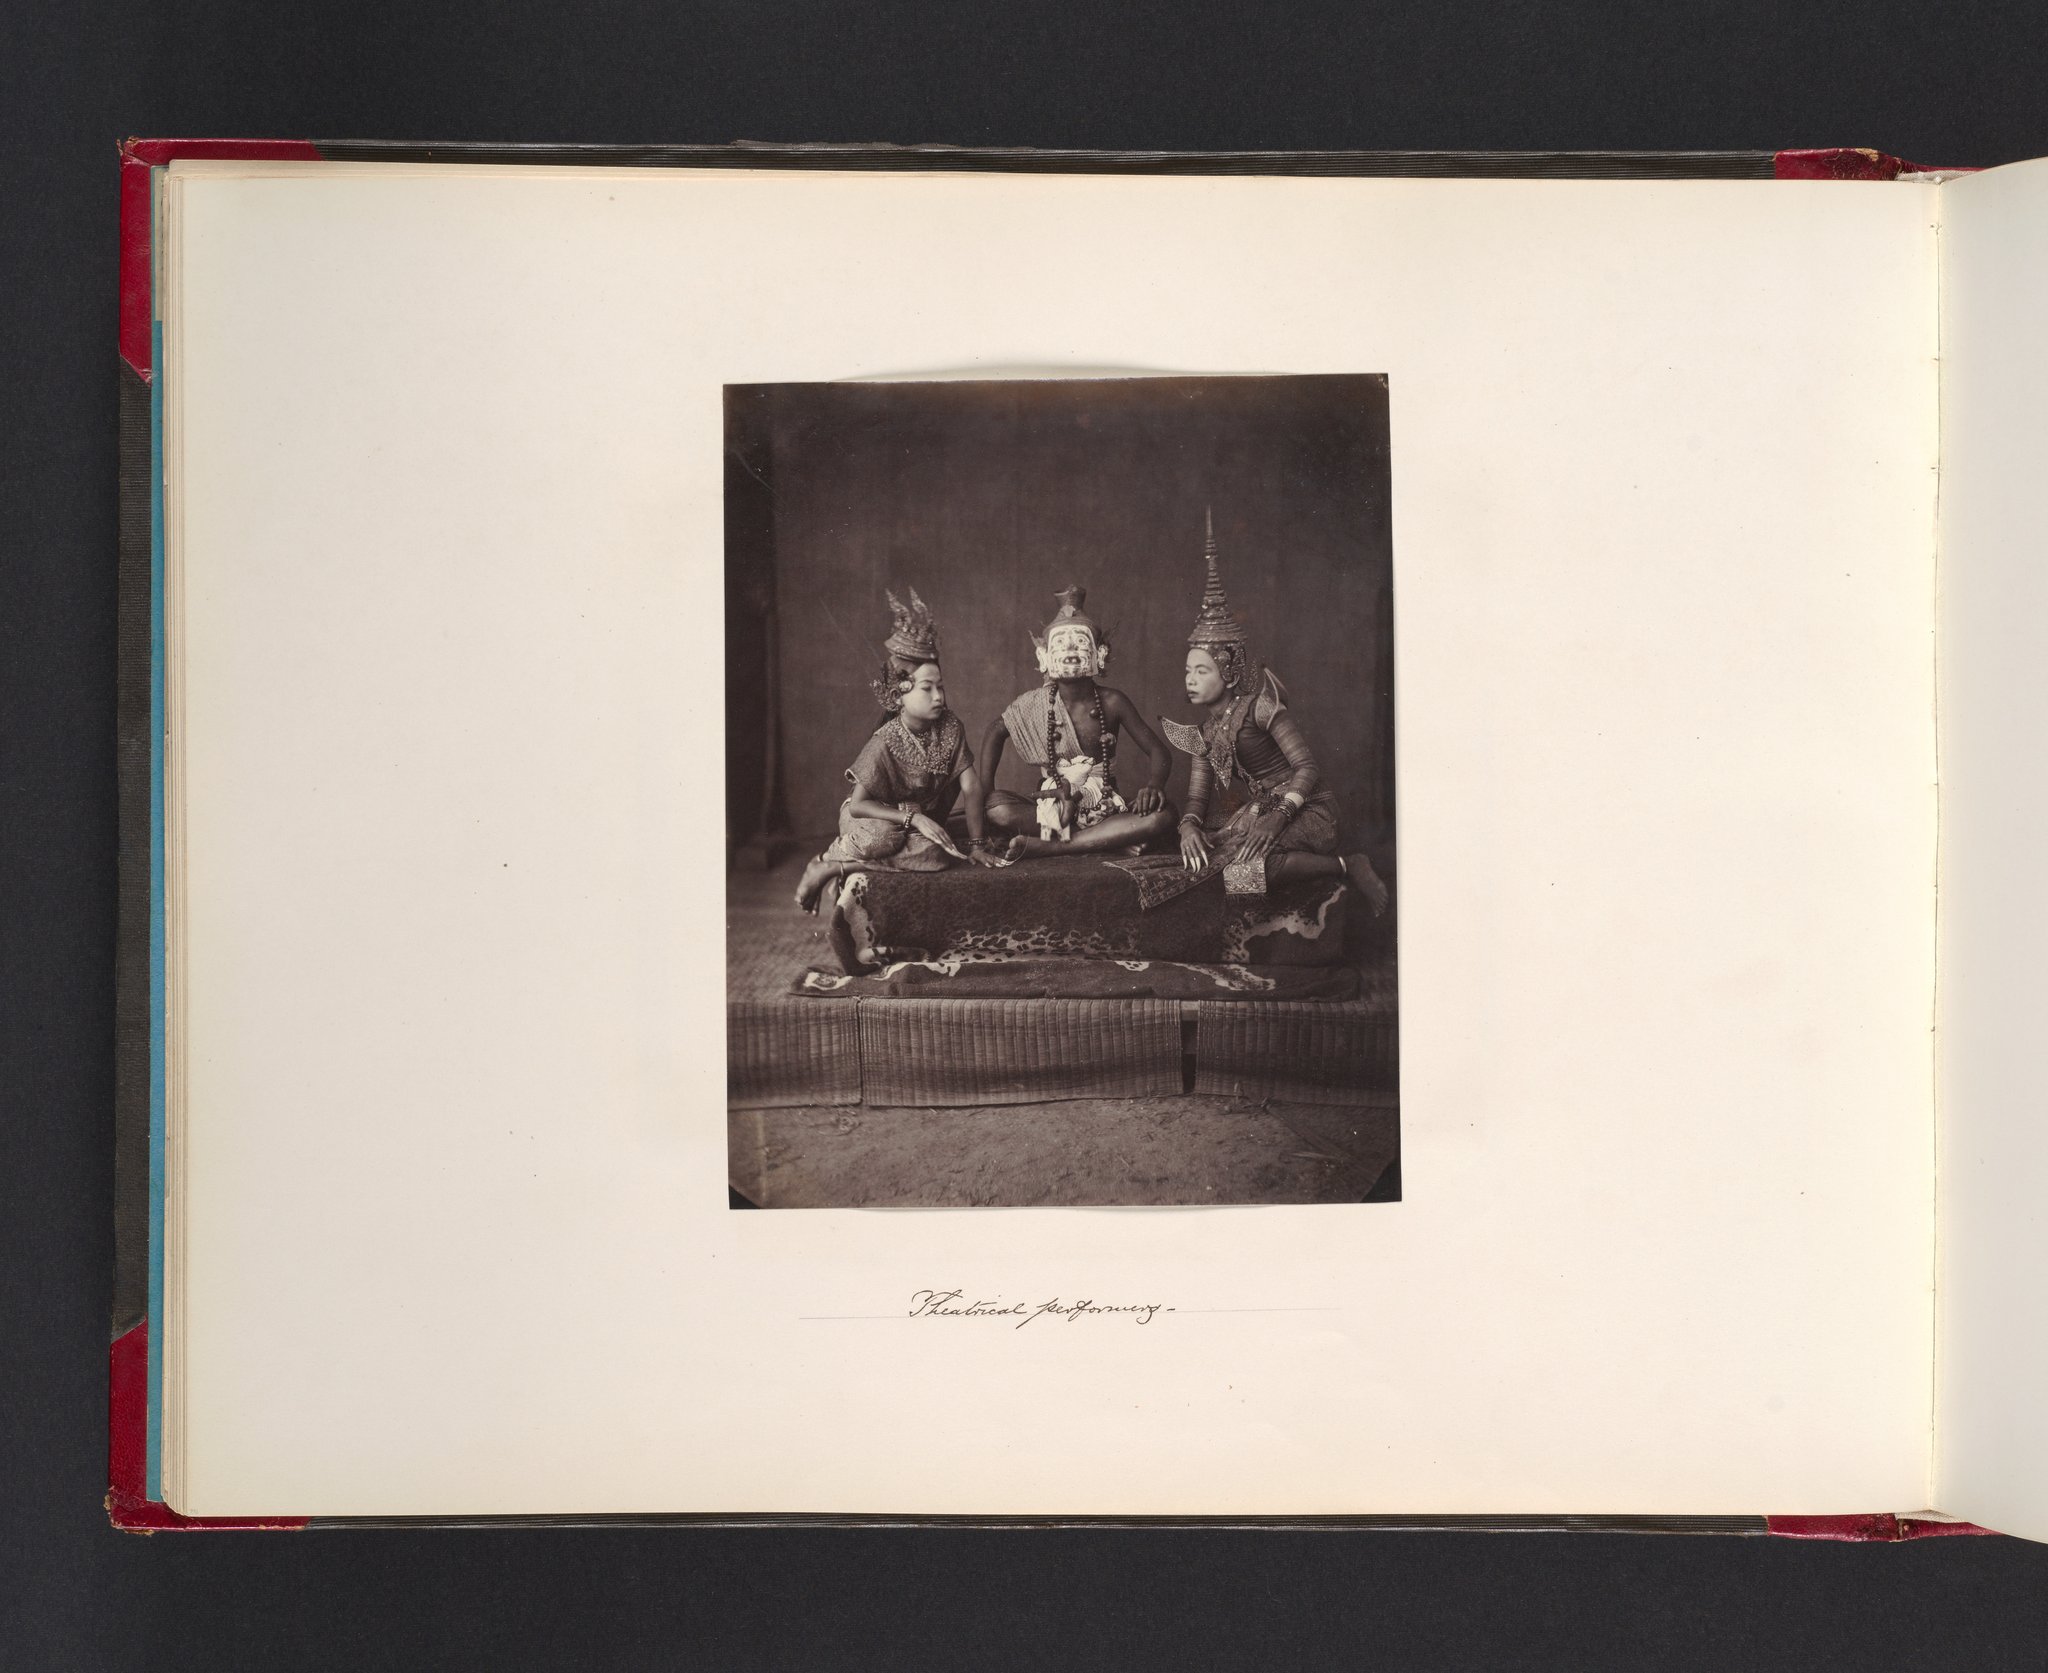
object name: photograph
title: Theatrical Performers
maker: john thomson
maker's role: artist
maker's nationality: british, scottish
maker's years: 1837-1921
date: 1865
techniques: albumen silver print, glass negative